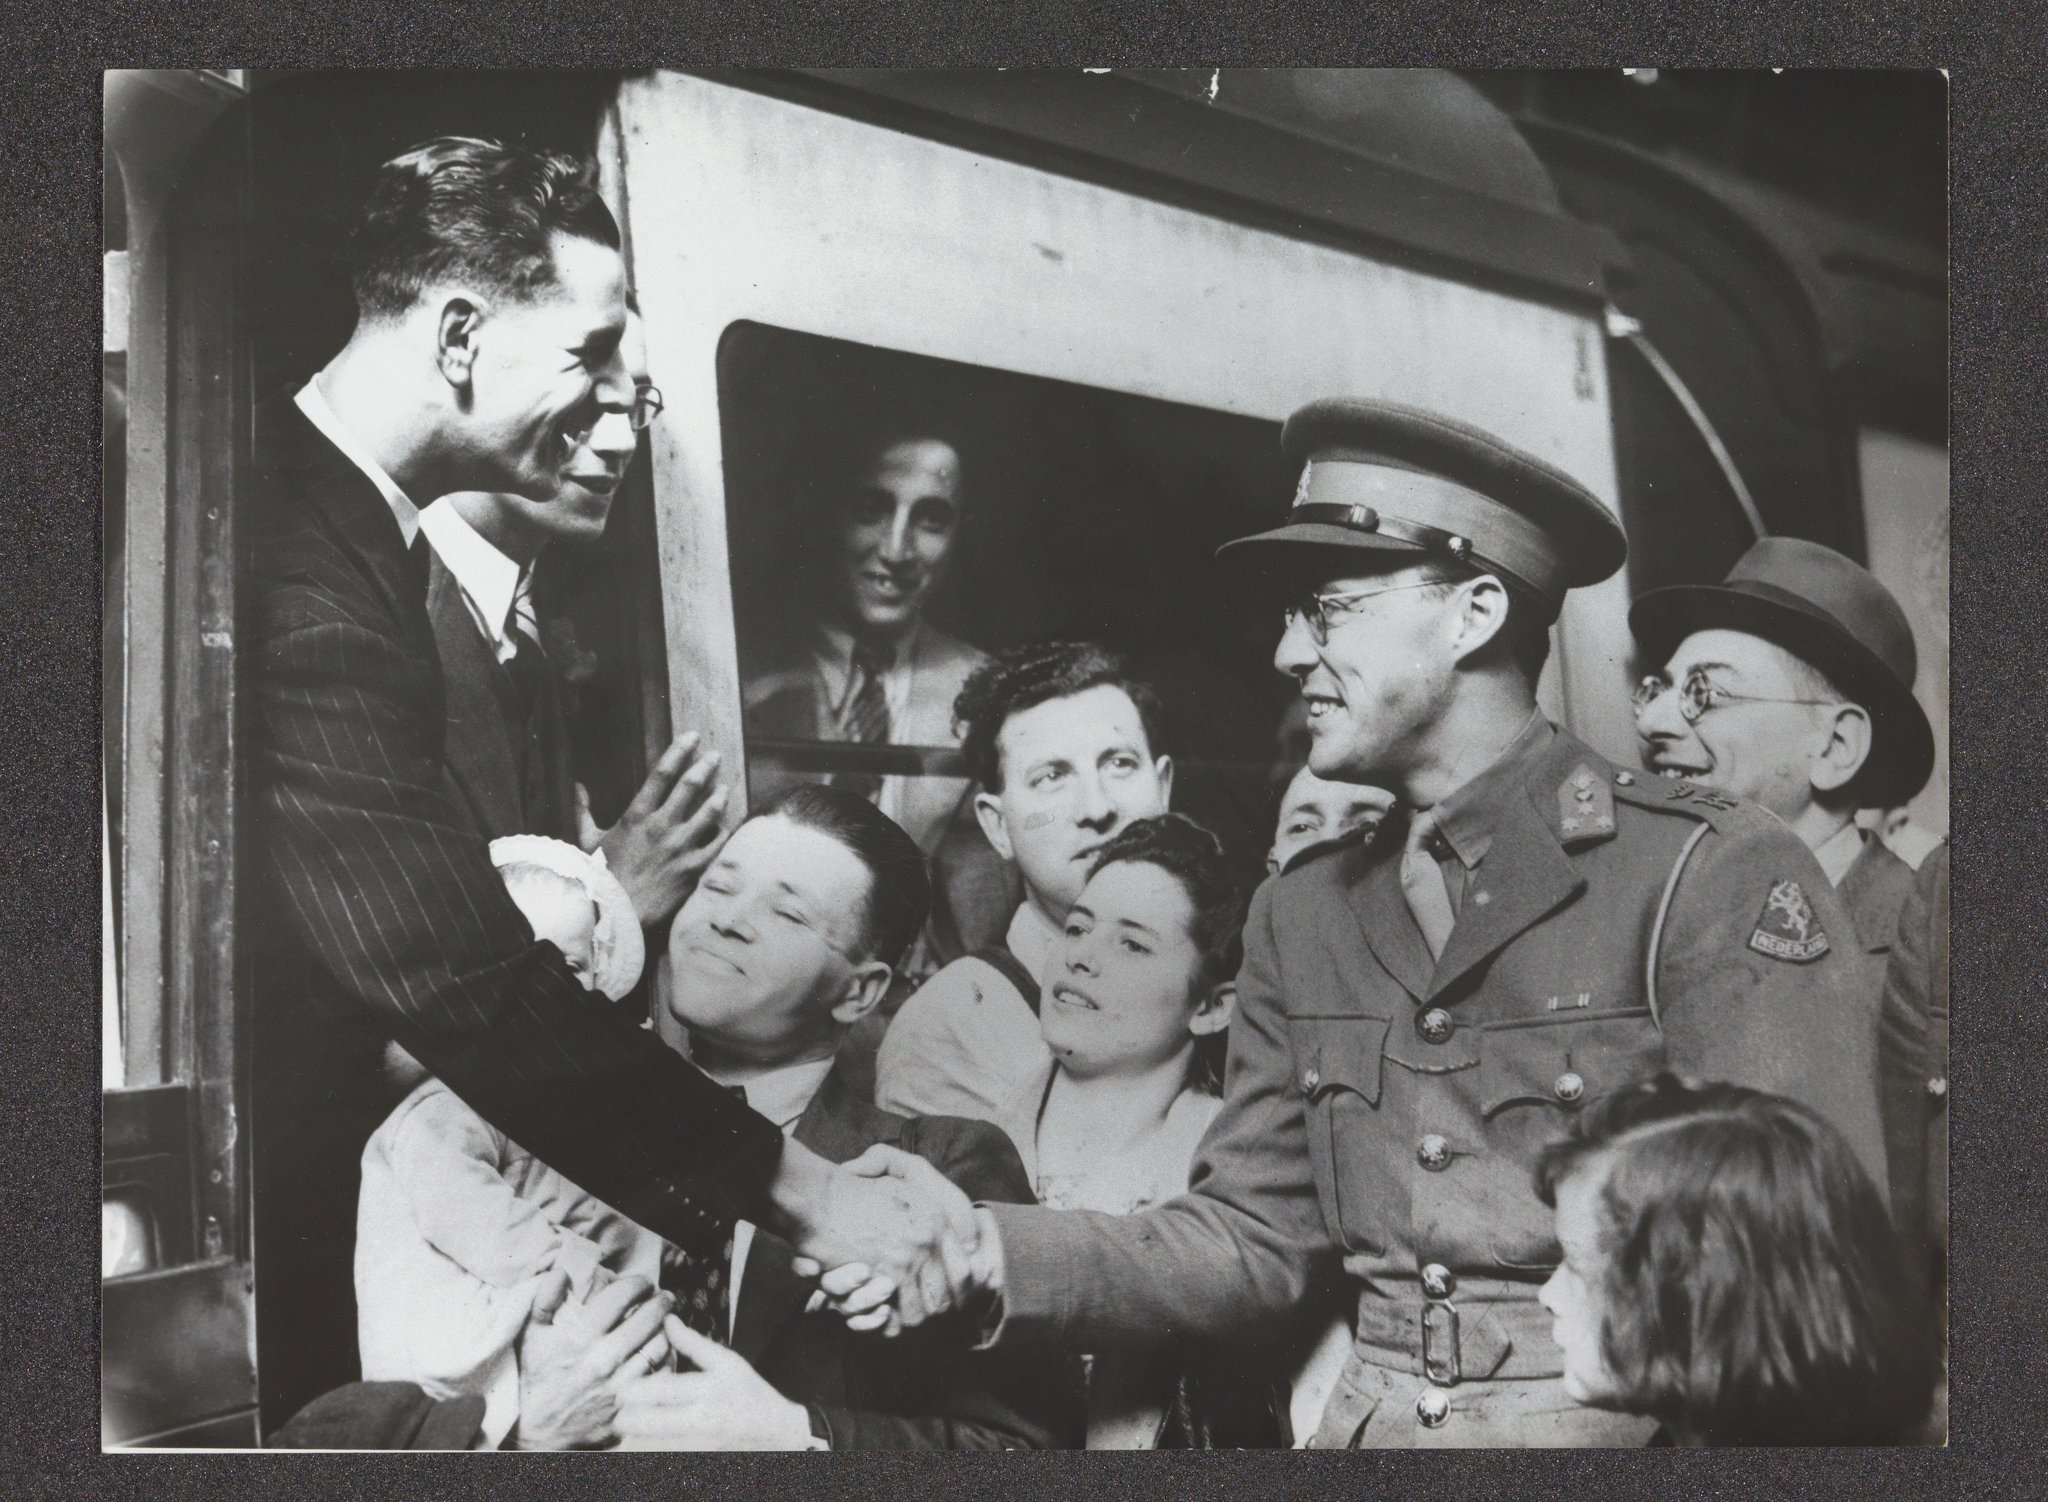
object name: photograph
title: Londen, Hollanders vertrekken naar trainingskamp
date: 1940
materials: paper, photographic support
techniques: gelatin silver print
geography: netherlands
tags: utrecht, bernhard (prins der nederlanden), london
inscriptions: annotation: ‘Copiright ANEFO Kerkstraat 310 Amsterdam-c HIE 22’